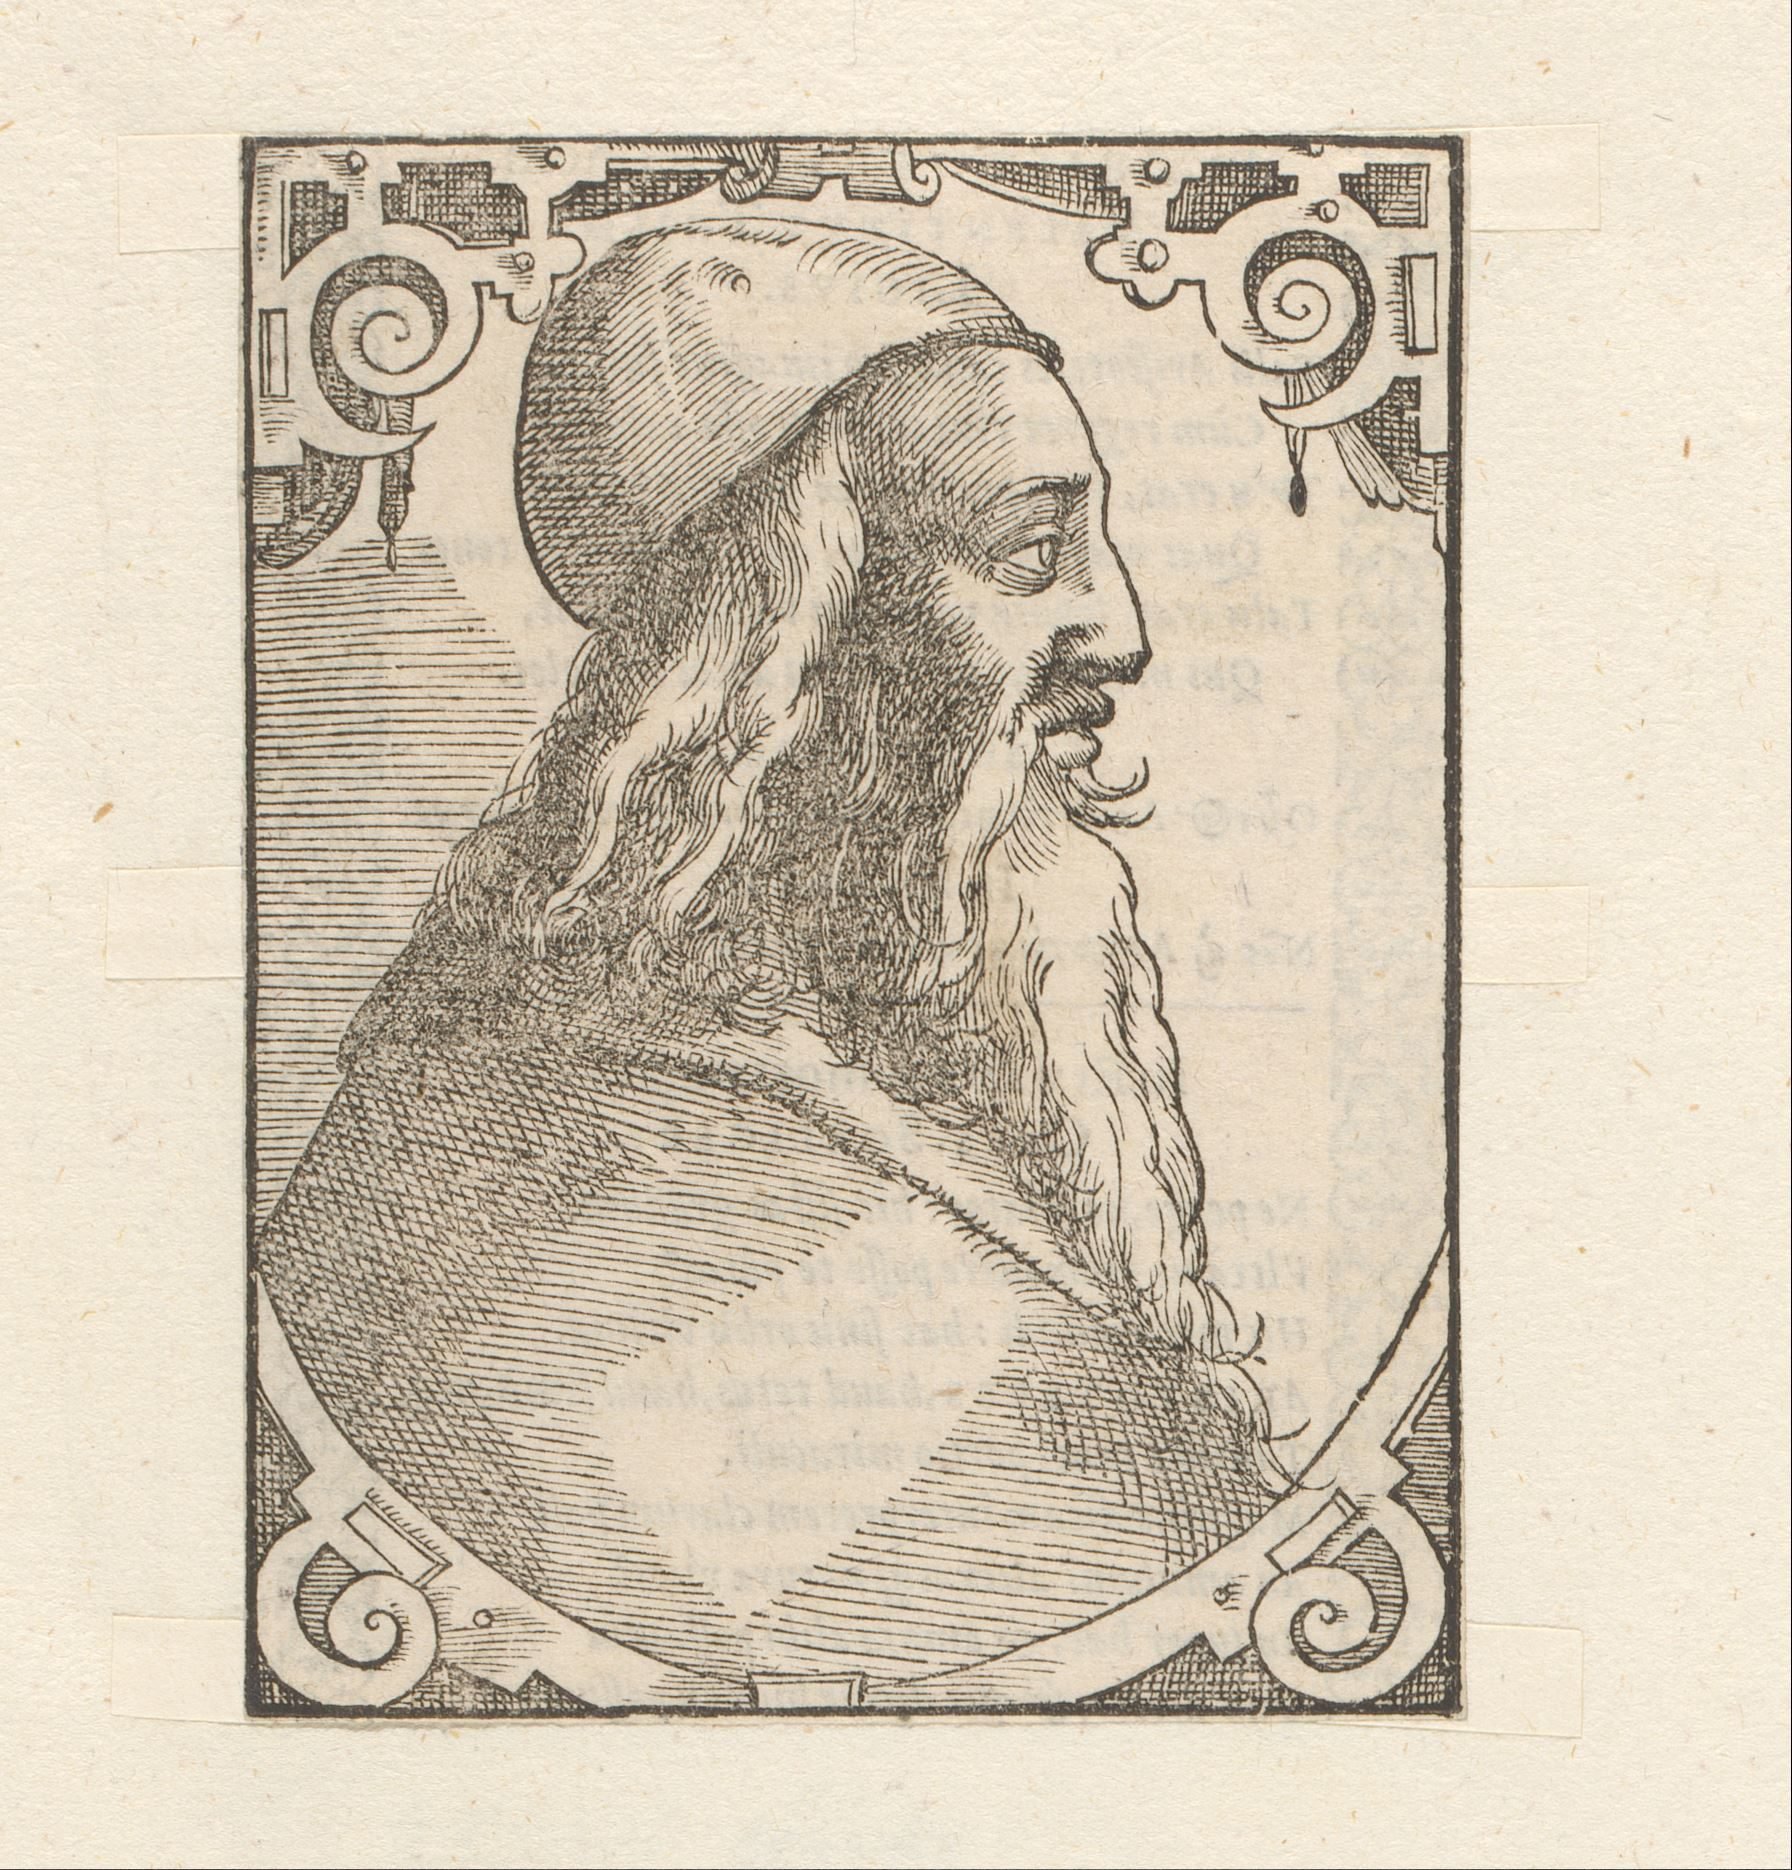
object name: book illustration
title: Portret van Aristoteles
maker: Anonymous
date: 1549-1584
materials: paper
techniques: letterpress printing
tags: historical persons, portrait of a writer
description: Prent gebruikt in: Reusner, Nikolaus. Icones Sive Imagines Vivae. Bazel: Conrad Waldkirch, 1589.